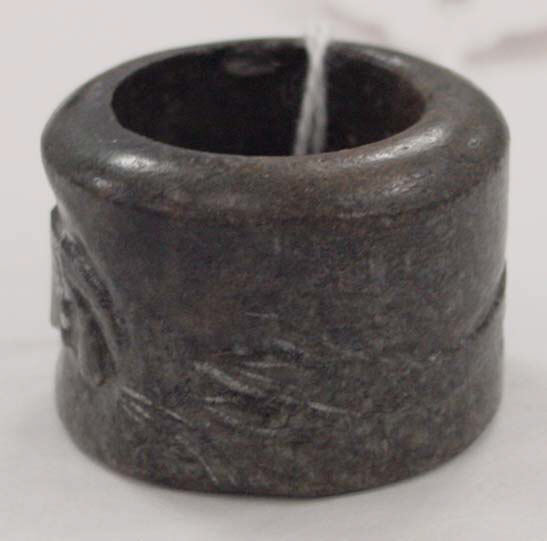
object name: ring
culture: chinese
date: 1801-1900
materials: jade